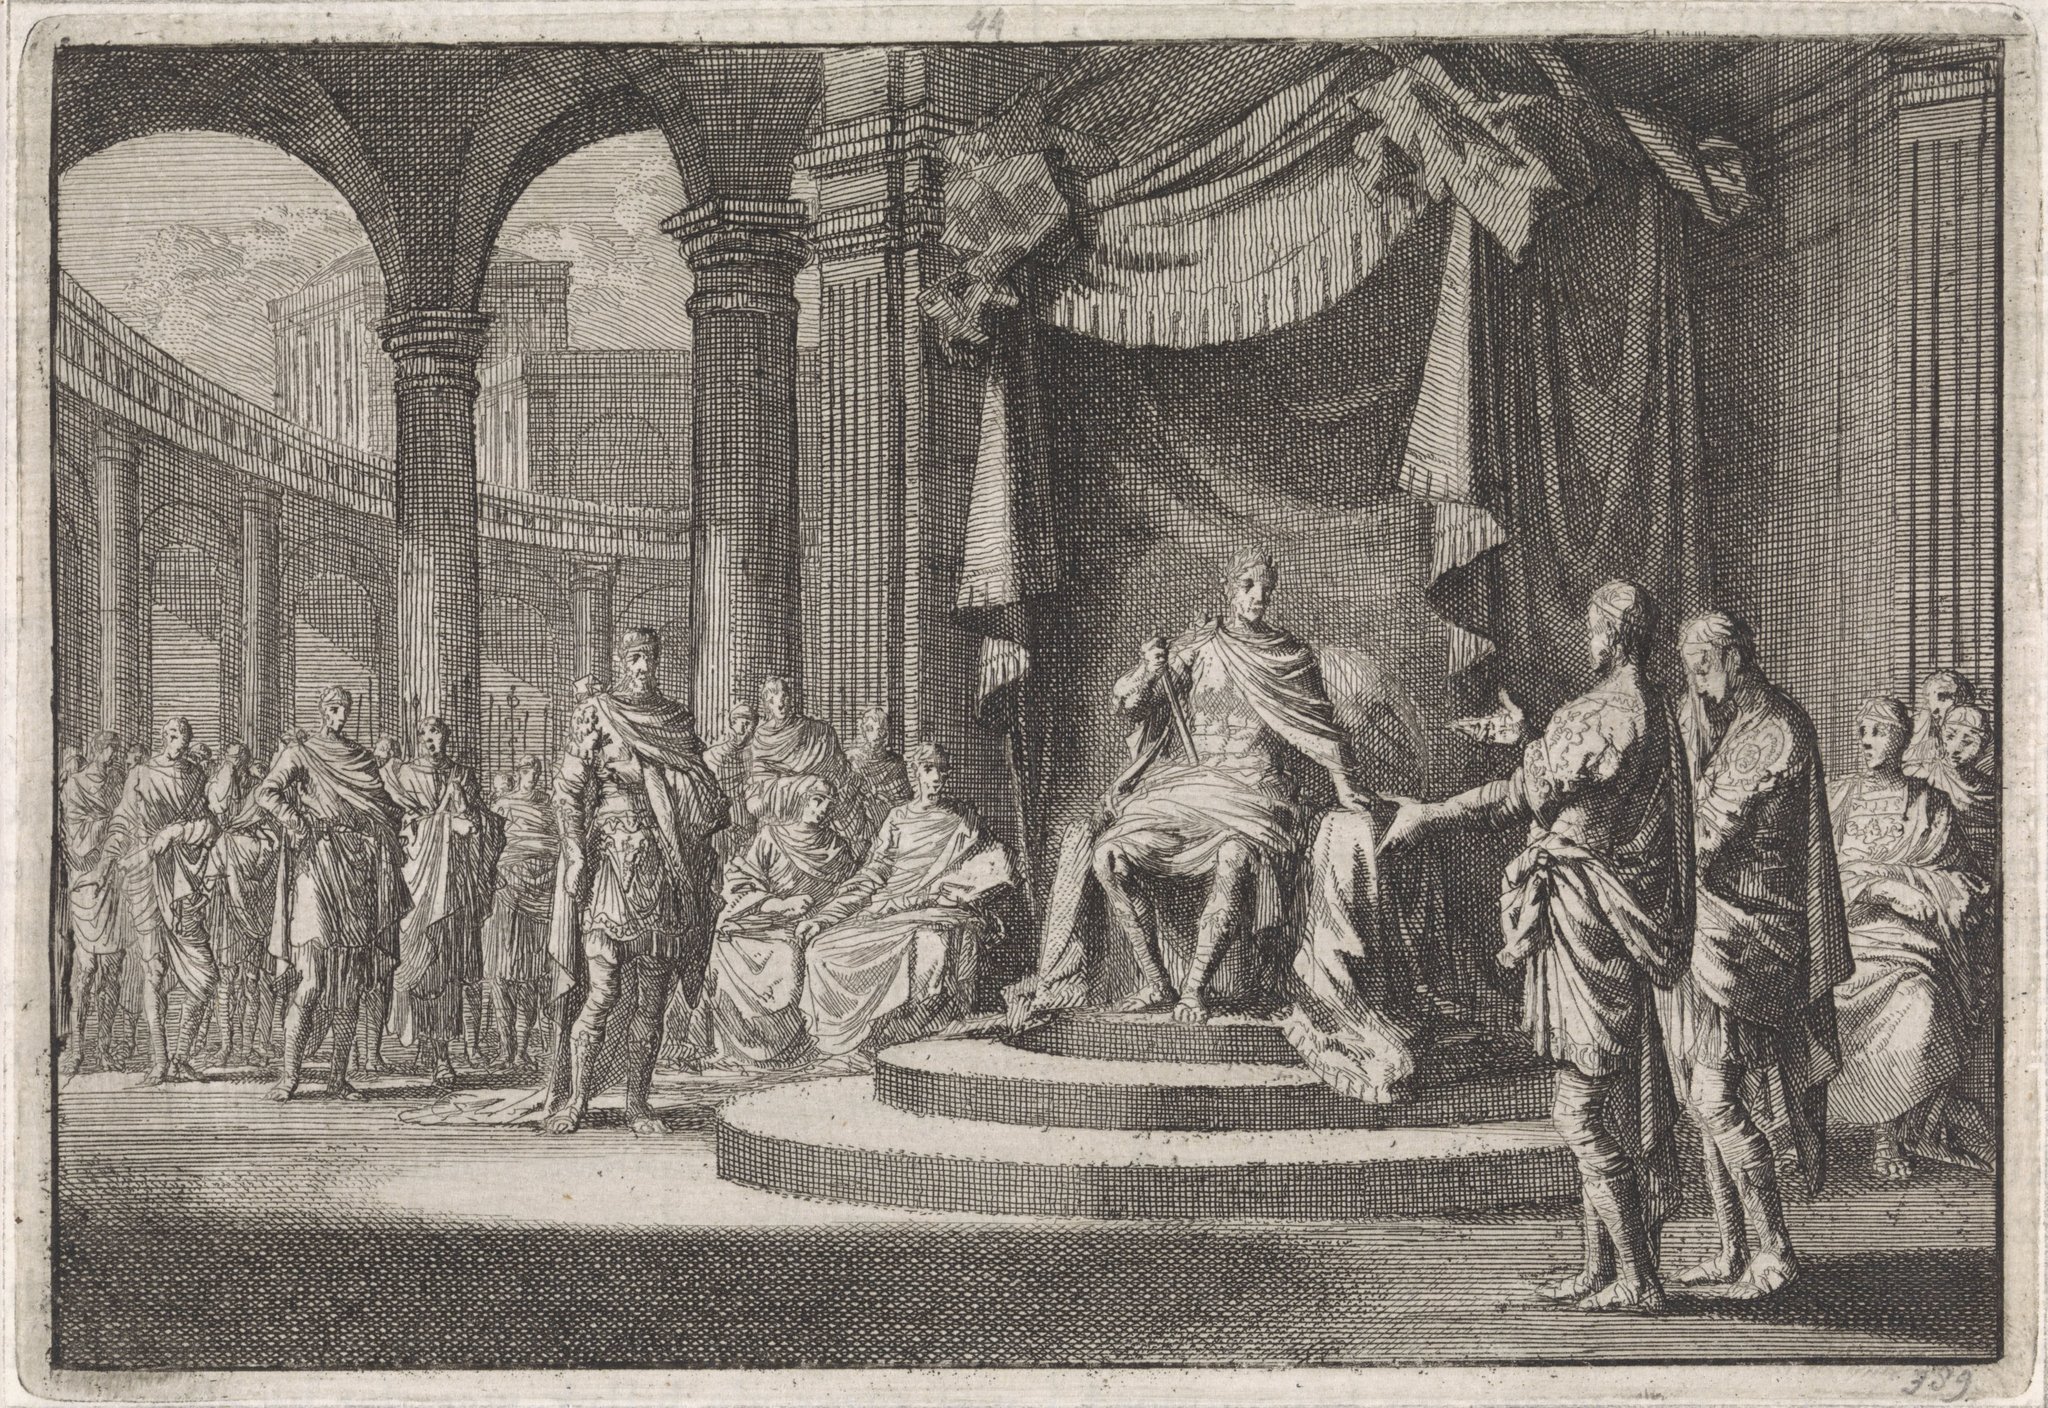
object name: book illustration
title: Alexander en Aristobulus verantwoorden zich voor keizer Augustus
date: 1704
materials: paper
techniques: etching, letterpress printing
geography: amsterdam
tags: emperor, audition; ruler giving audience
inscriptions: collector's mark: Lugt 2228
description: Prent opgenomen in: Josephus, Flavius. Alle de Werken, 2 delen. Amsterdam: Pieter Mortier, 1704, dl. 1, p. 389.